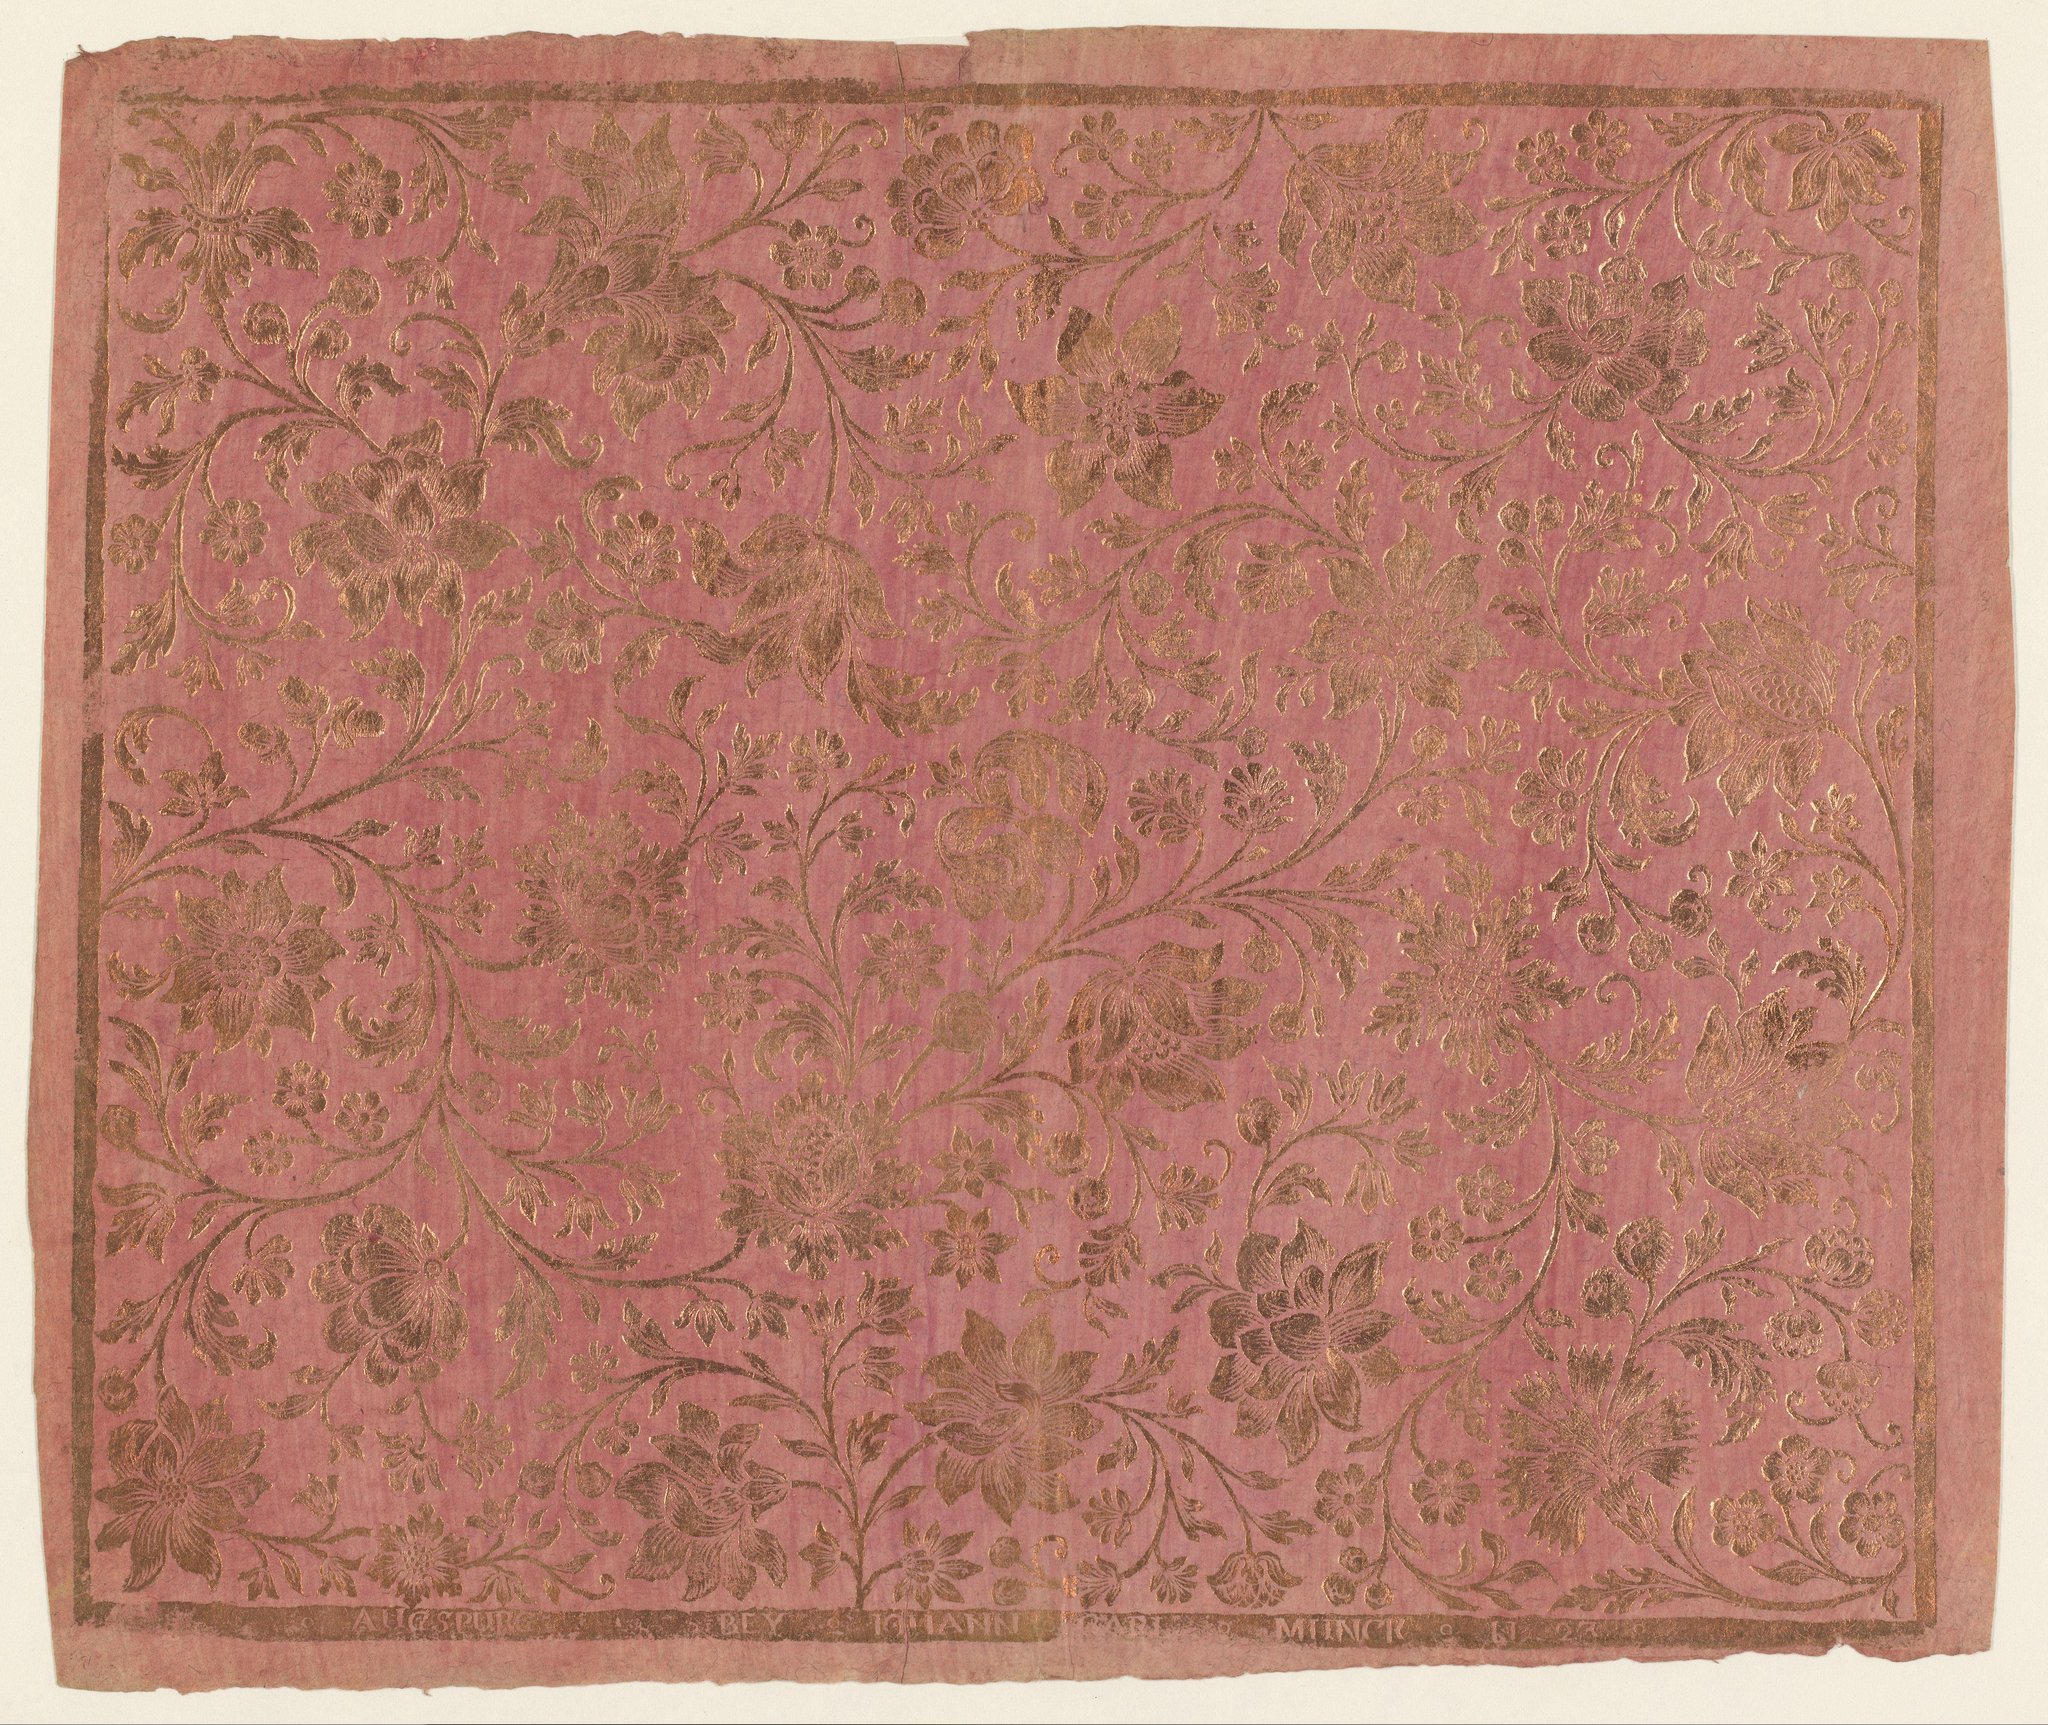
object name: brocade paper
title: Blad met ranken met bloemen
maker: johann carl munck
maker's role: ontwerper sierpapier, papiermaker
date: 1750-1794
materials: gold leaf, paint, paper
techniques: relief print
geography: augsburg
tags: ornament derived from plant forms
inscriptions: collector's mark: Lugt 2760, collector's mark: Lugt 2228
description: Blad met ranken met bloemen. Rechtsonder een anjer. Onderaan genummerd: No. 23.